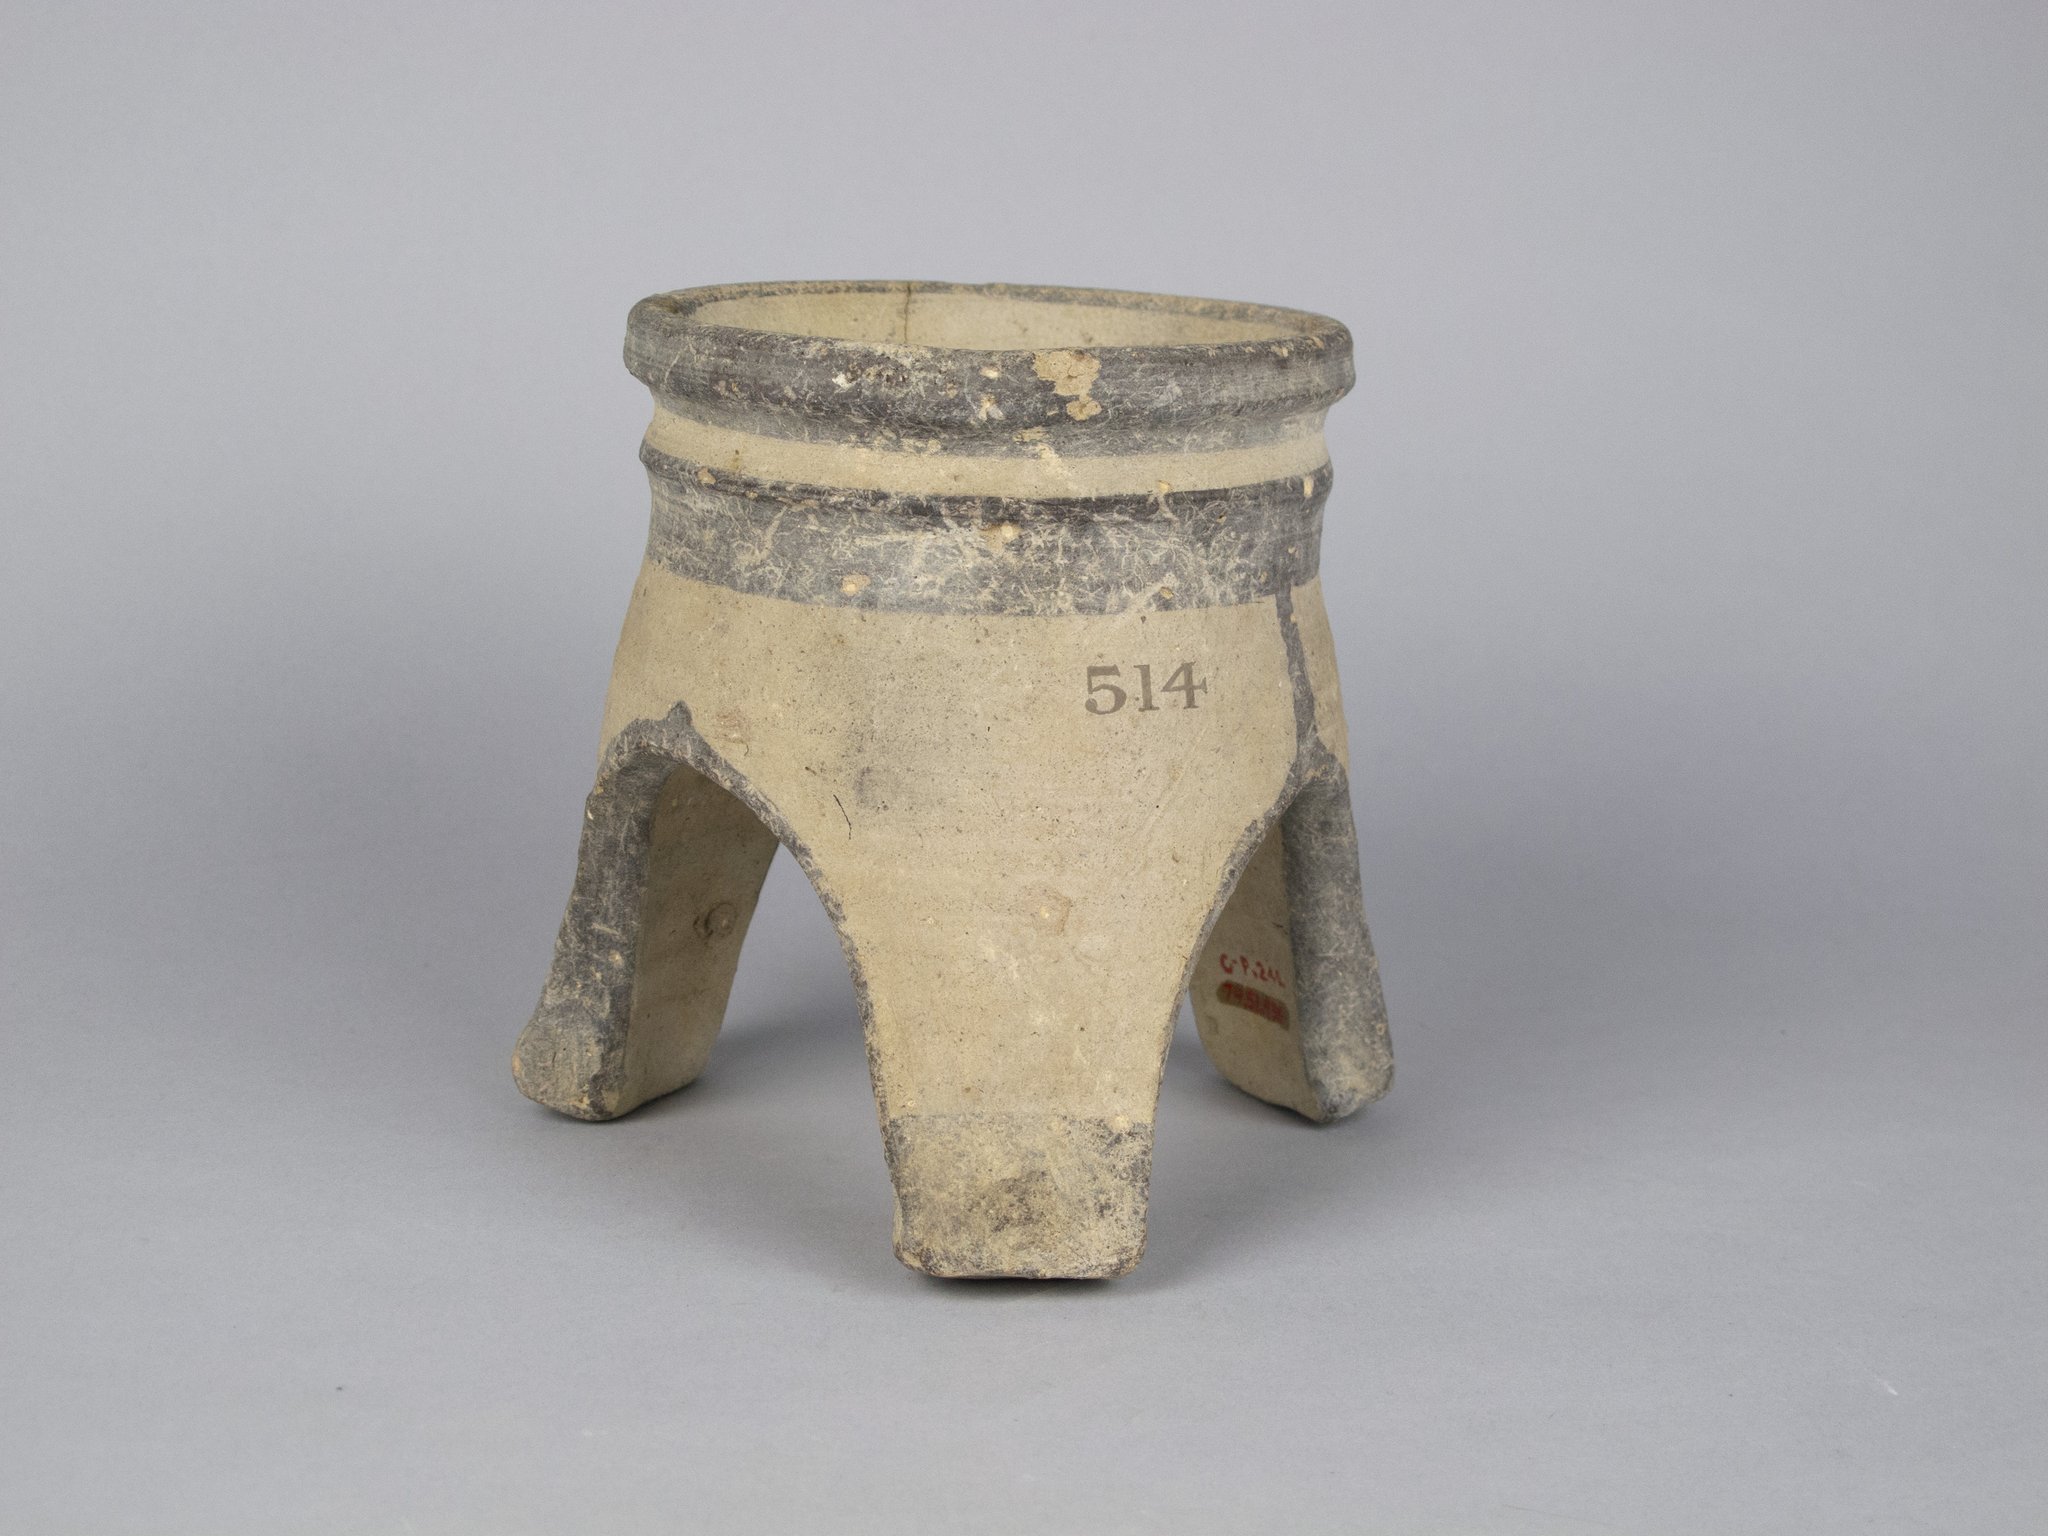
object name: tripod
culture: cypriot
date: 1050-950 BCE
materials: terracotta